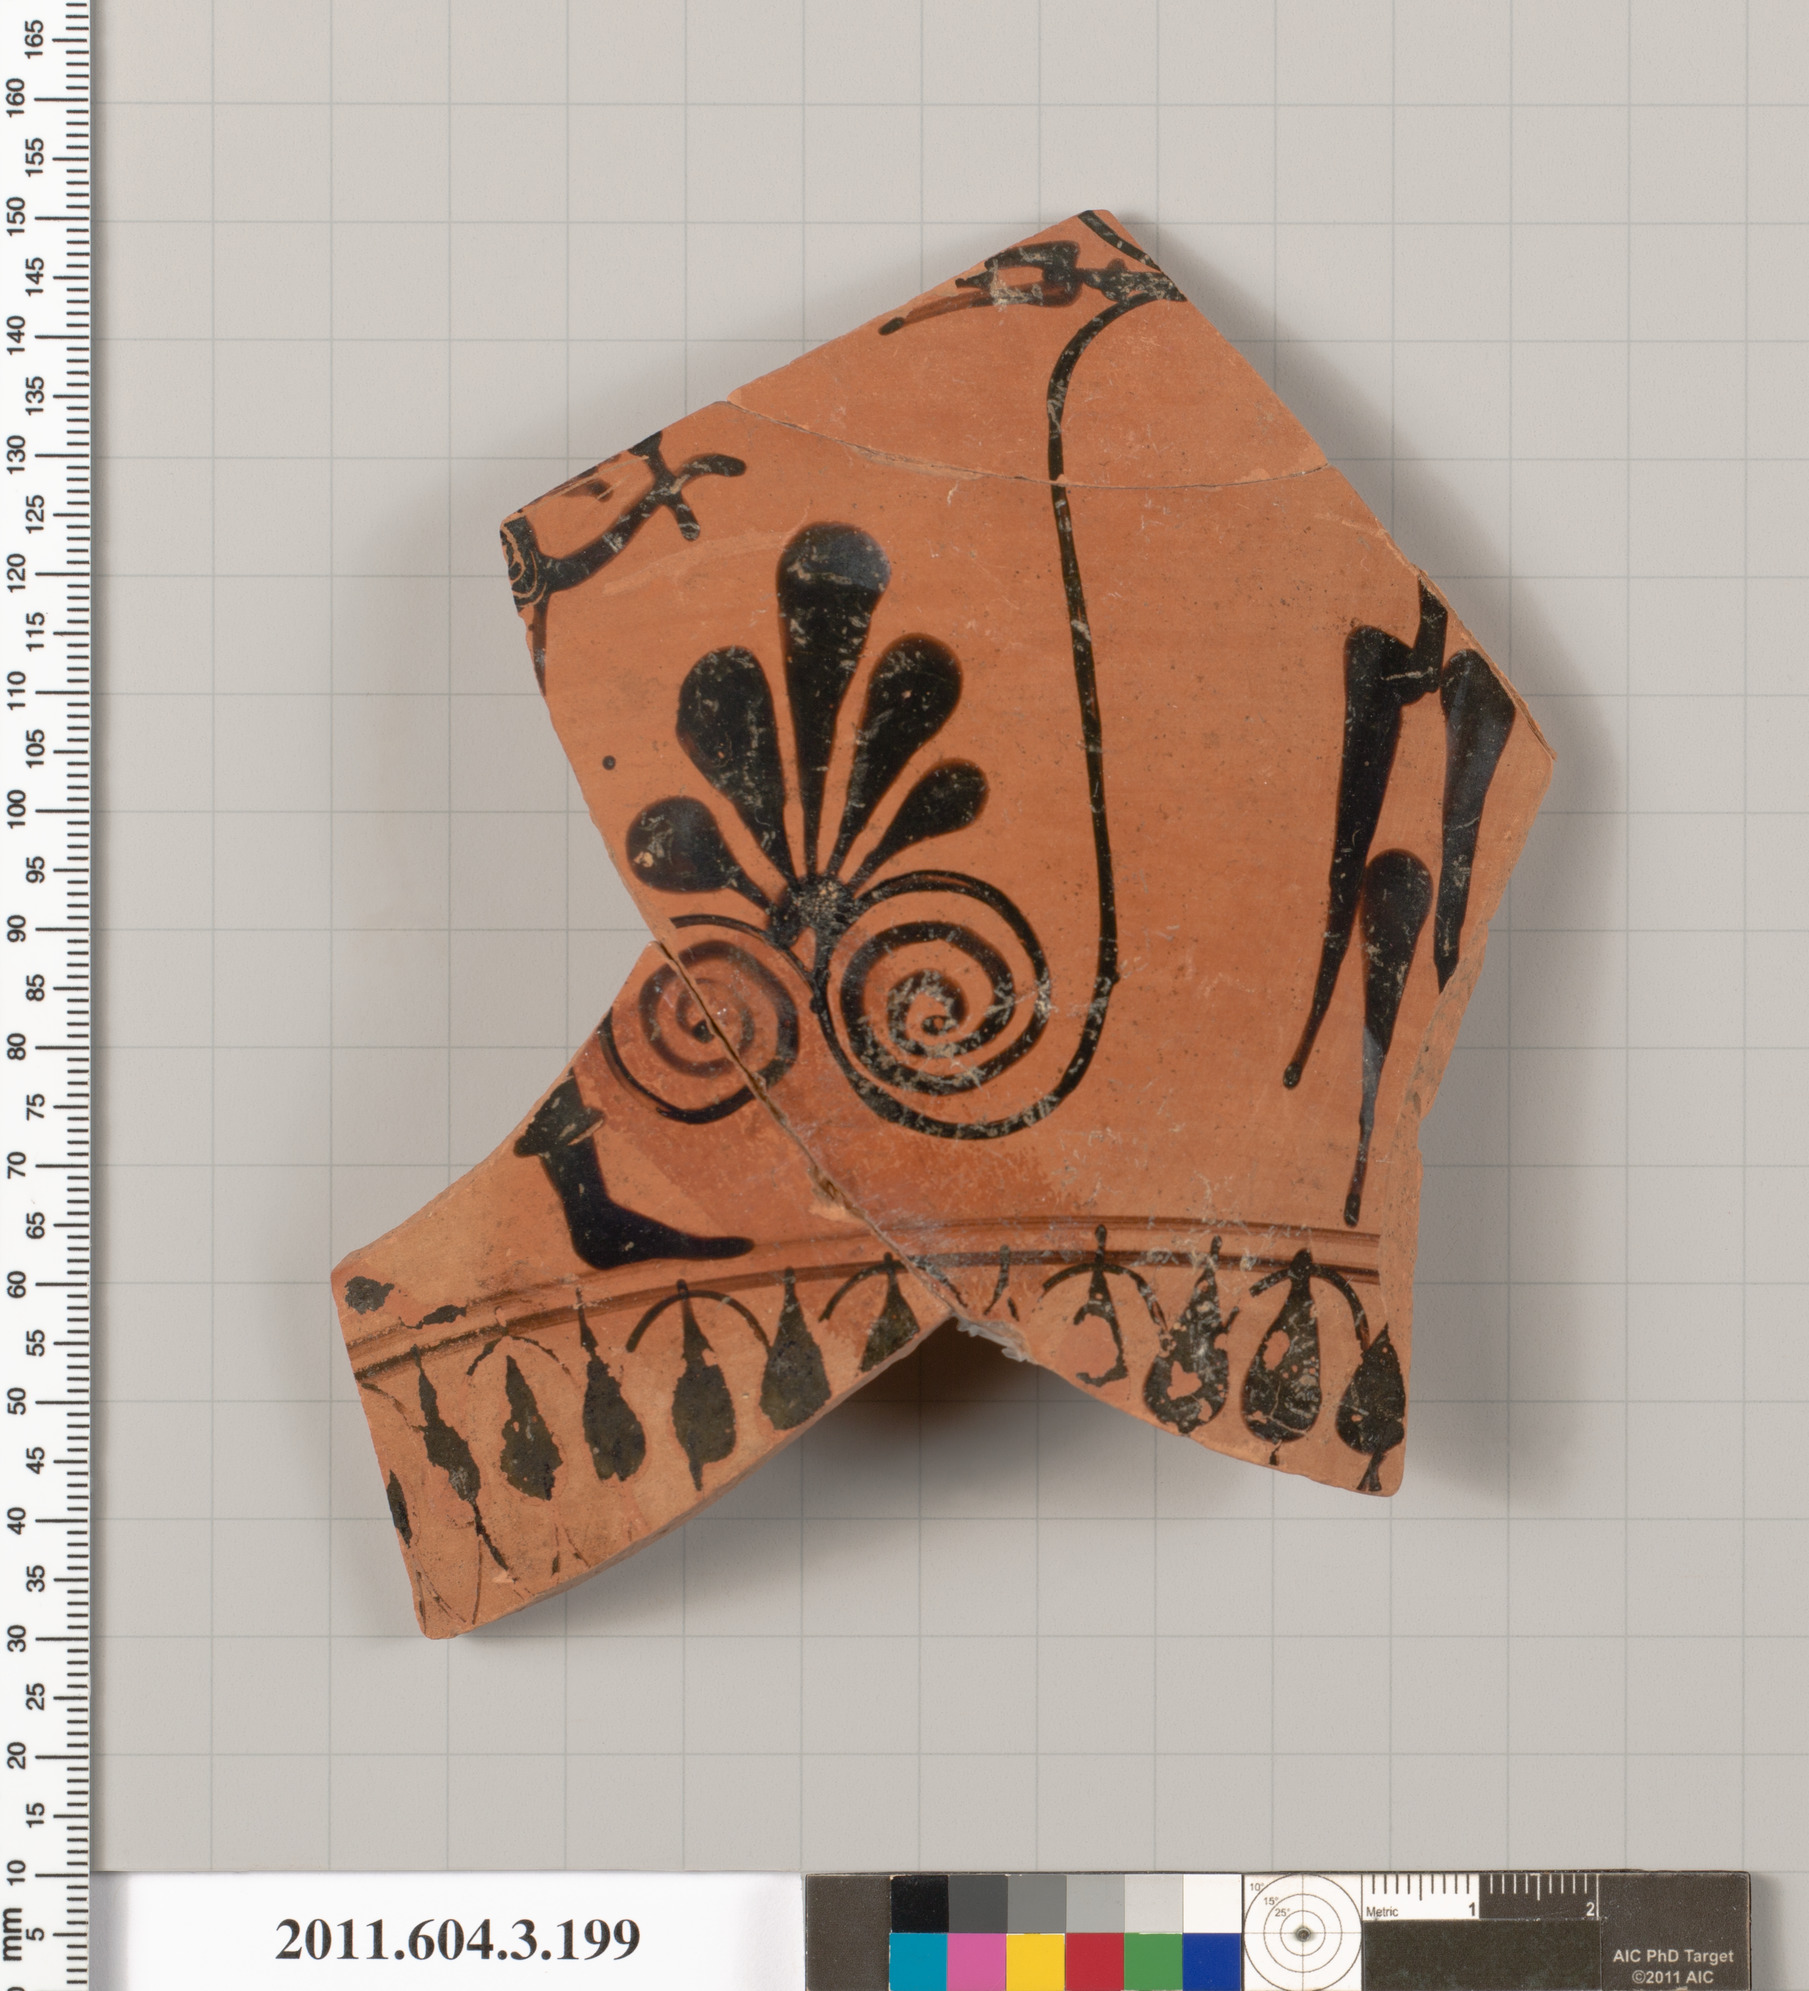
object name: neck amphora fragment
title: Terracotta fragment of a neck-amphora (jar)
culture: greek, attic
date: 530-520 BCE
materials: terracotta